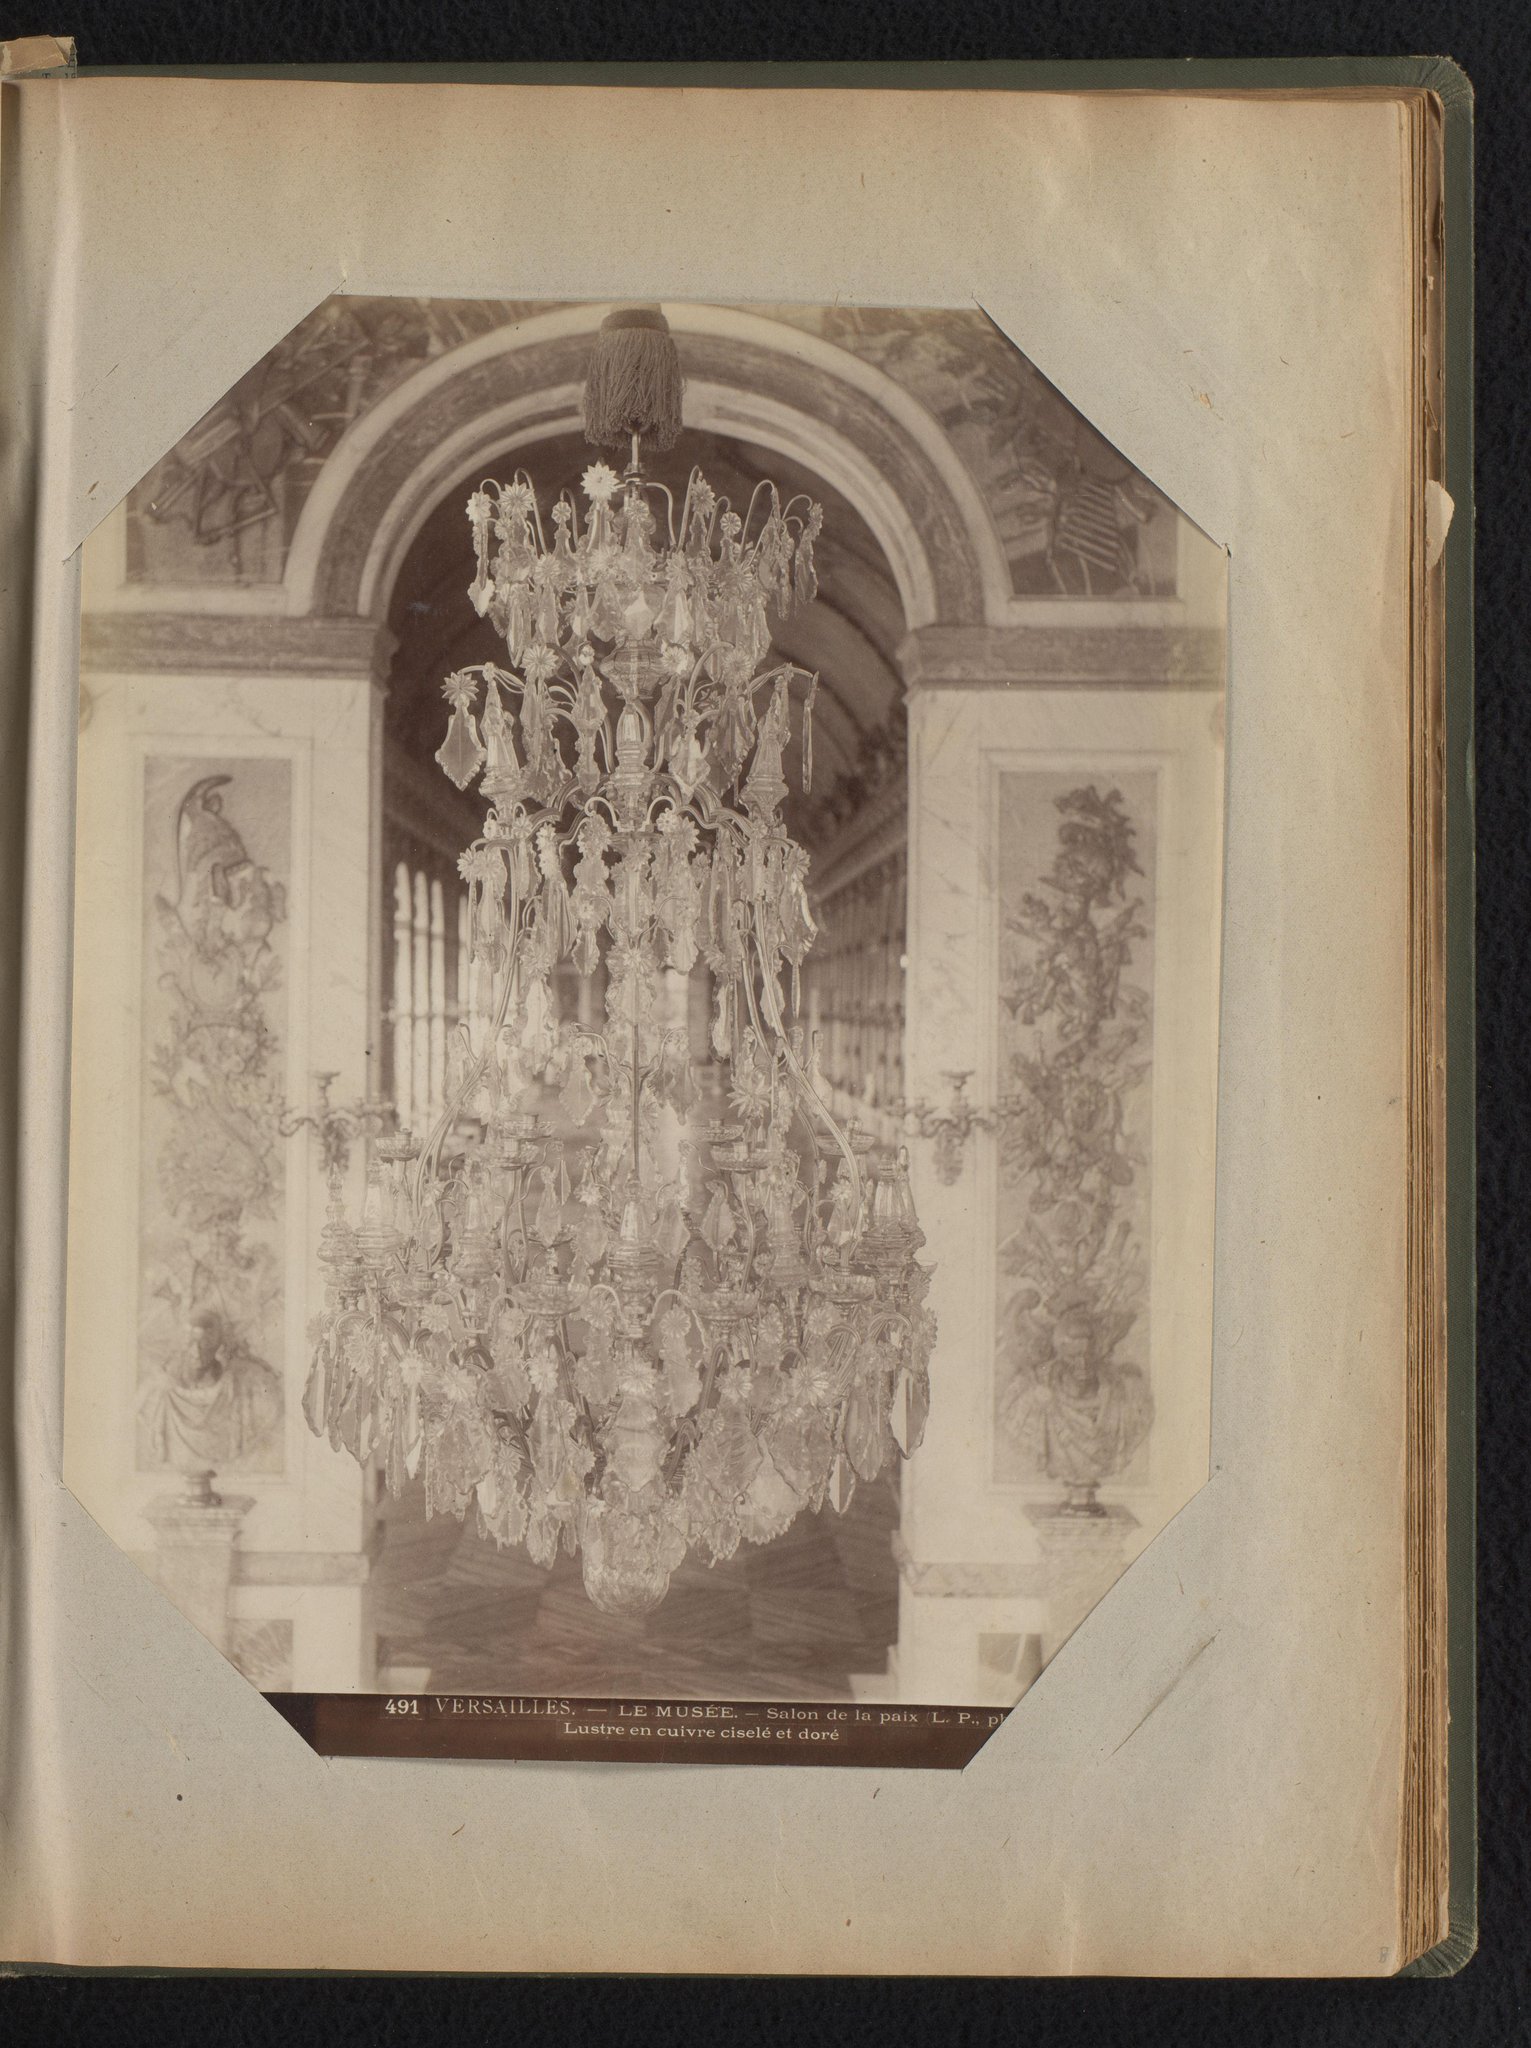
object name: photograph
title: Bronzen, vergulde kroonluchter met kristallen ornamenten in paleis Versailles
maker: Anonymous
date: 1860-1900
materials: canvas, cardboard, paper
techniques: matte daylight collodion silver print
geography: netherlands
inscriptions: annotation: ‘491. Versailles - Le Musee - Salon de la paix (L.P. Phot). Lustre en cuivre cisele et doré.’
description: Onderdeel van een serie met betrekking tot het interieur van het paleis van Versailles met kroonluchters, deuren, portalen en meubelstukken.